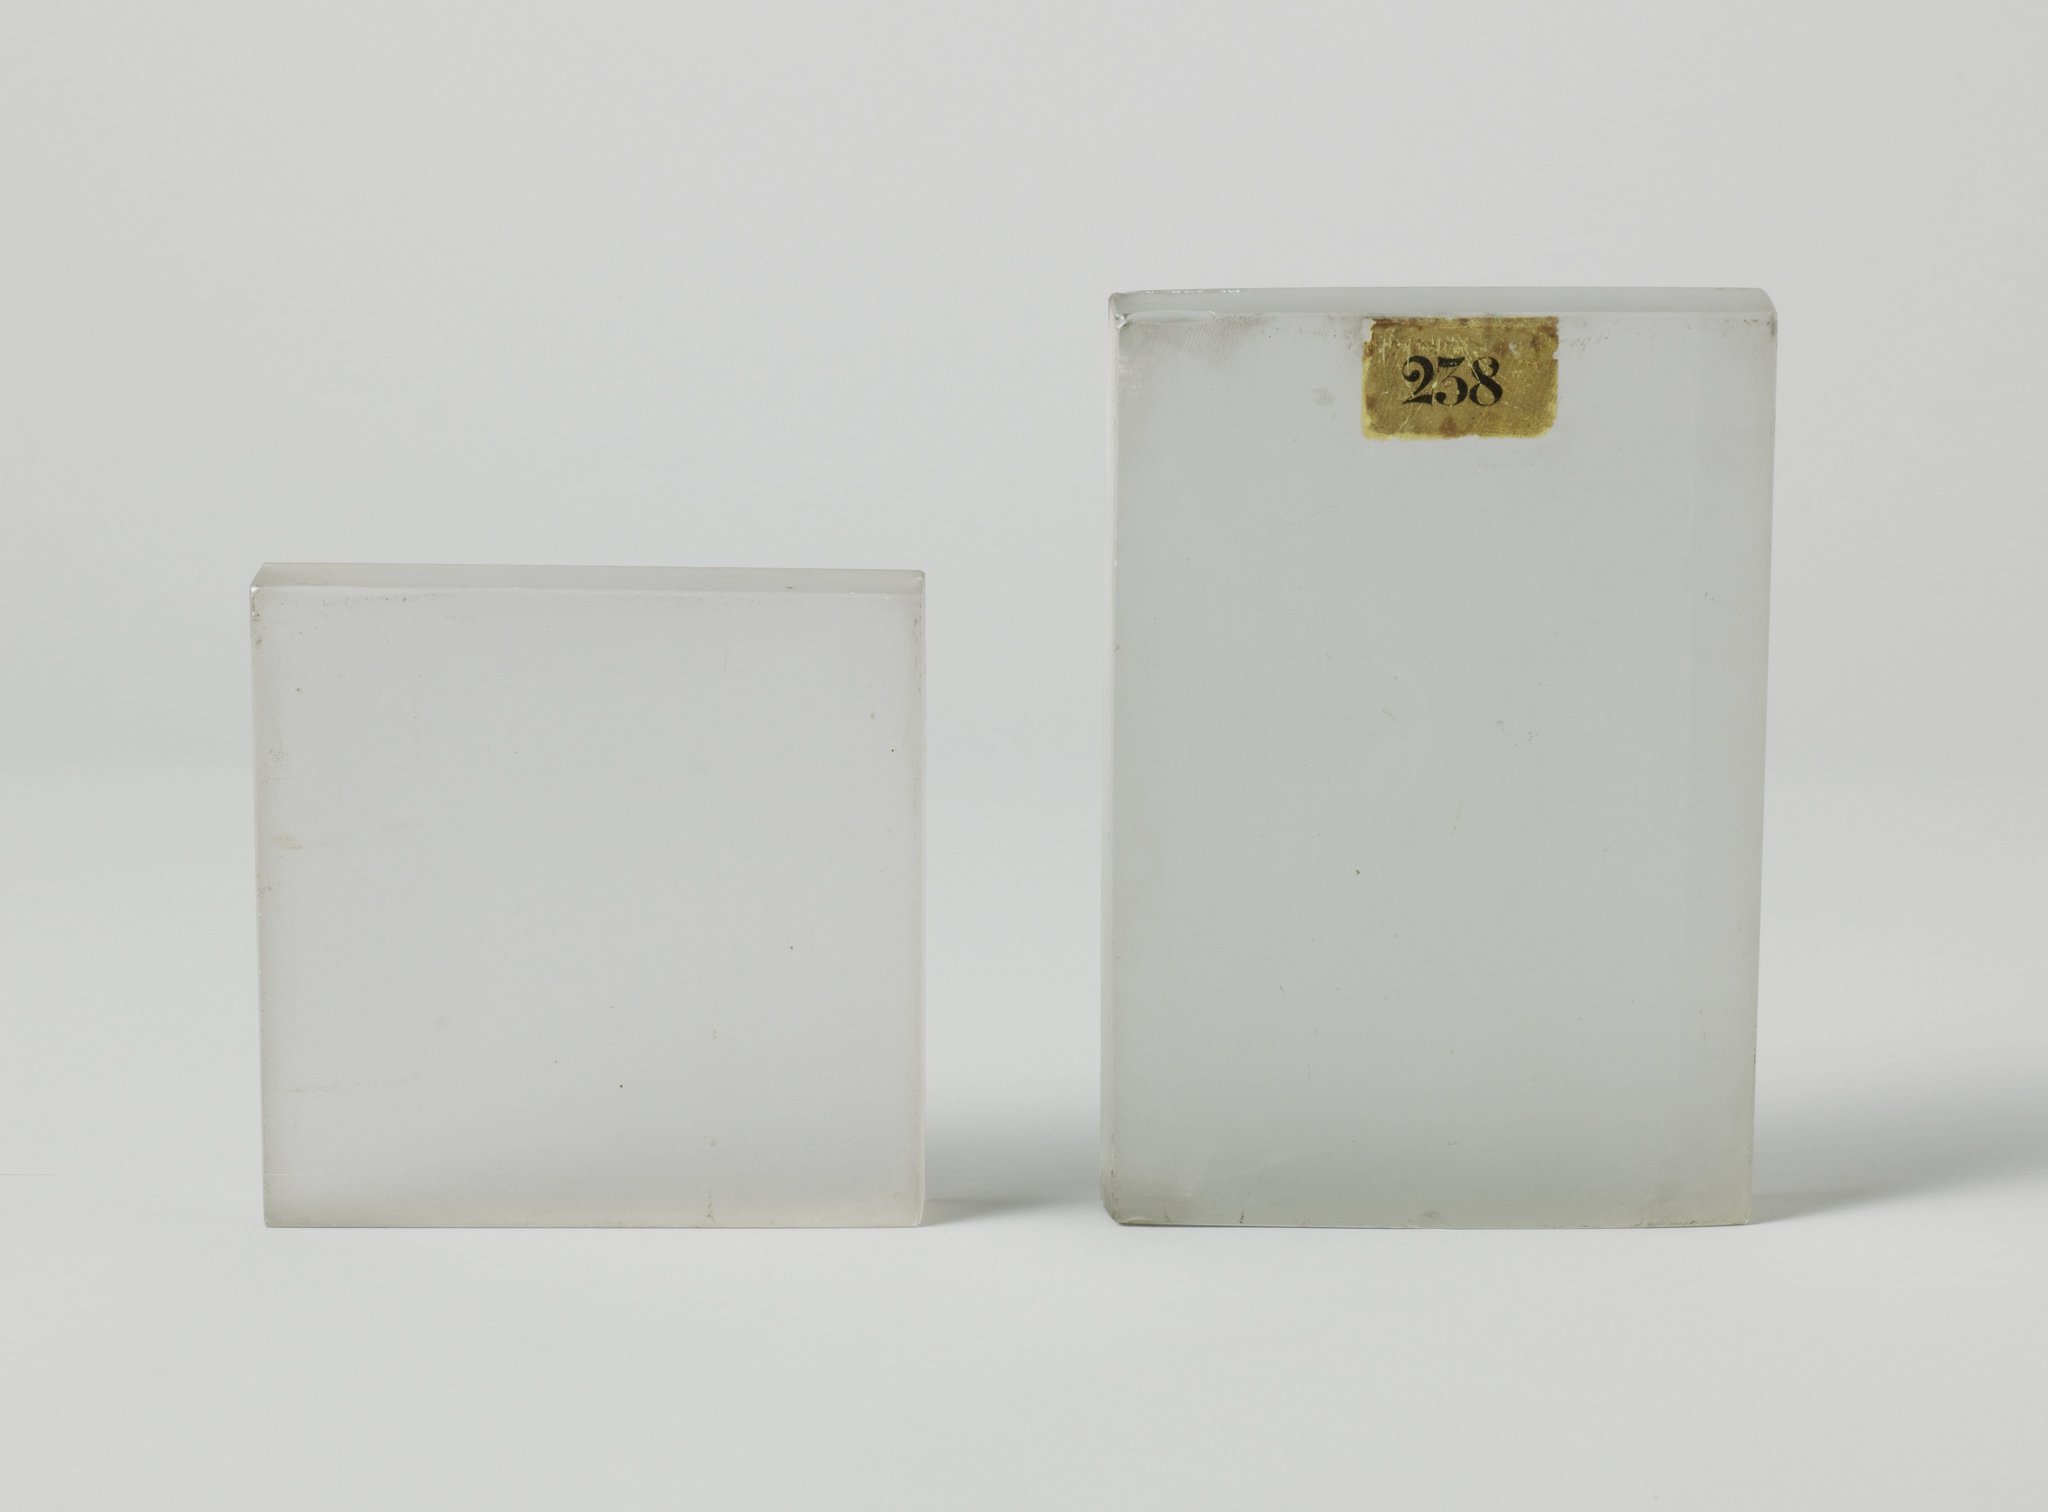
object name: portlight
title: Two Portlights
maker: Anonymous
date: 1832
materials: glass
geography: netherlands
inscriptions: label, on portlight 1, top centre: ‘238’ former inventory label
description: Obreens toeschrijving van dit model aan de fabriek van Regout in Maastricht wordt nog door geen enkel bewijsmateriaal gestaafd, noch zijn er vier modellen gevonden zoals in de catalogus beschreven. Het model door P. Schuijt jr. in 1832 gemaakt en werden ter beoordeling door een commissie van constructeurs (P. Schuijt jr., P. Glavimans Jz. en C. Soetermeer.) naar Rotterdam gezonden. De houten en koperen vattingen die in de archiefstukken worden genoemd, ontbreken. Met inachtneming van enkele kleine wijzigingen werd zij goedgekeurd.